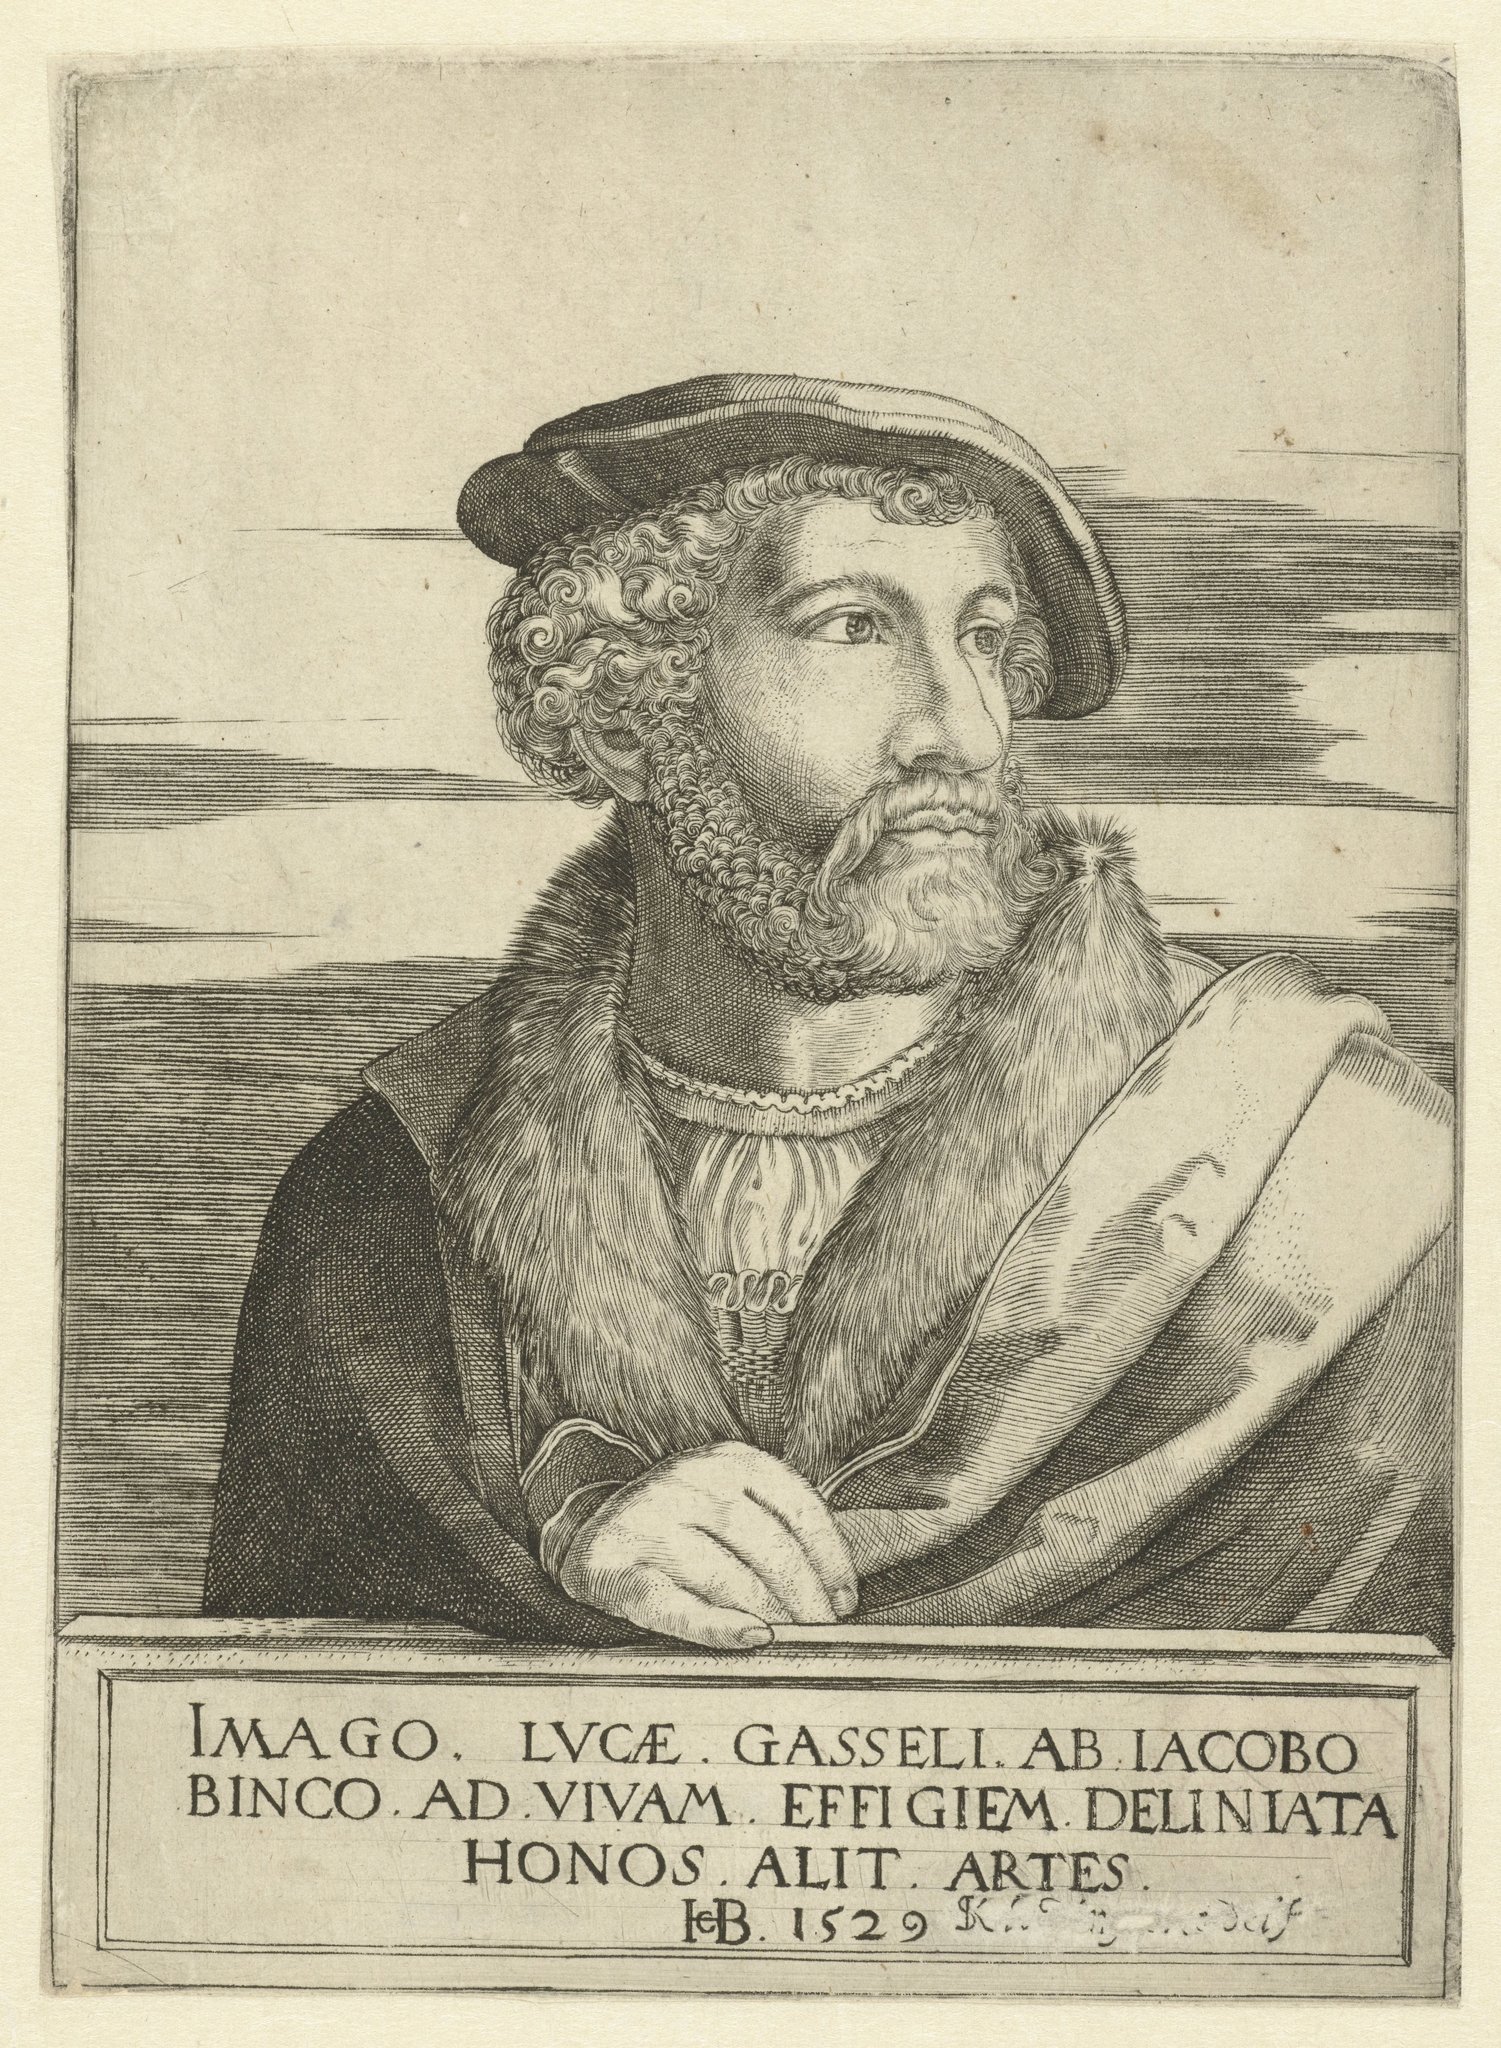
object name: print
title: Portret van de schilder Lucas Gassel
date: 1645-1676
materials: paper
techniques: engraving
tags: print maker, draughtsman, lucas gassel, portrait, self-portrait of painter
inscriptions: collector's mark: Lugt 240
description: Kopie in spiegelbeeld naar prent van Jakob Binck. Het Latijnse opschrift met de naam van de geportretteerde van de originele prent is volledig overgenomen: IMAGO LVCAE GASSELI AB IACOBO BINCO AD VIVAM EFFIGIEM DELINIATA HONOS ALIT ARTES